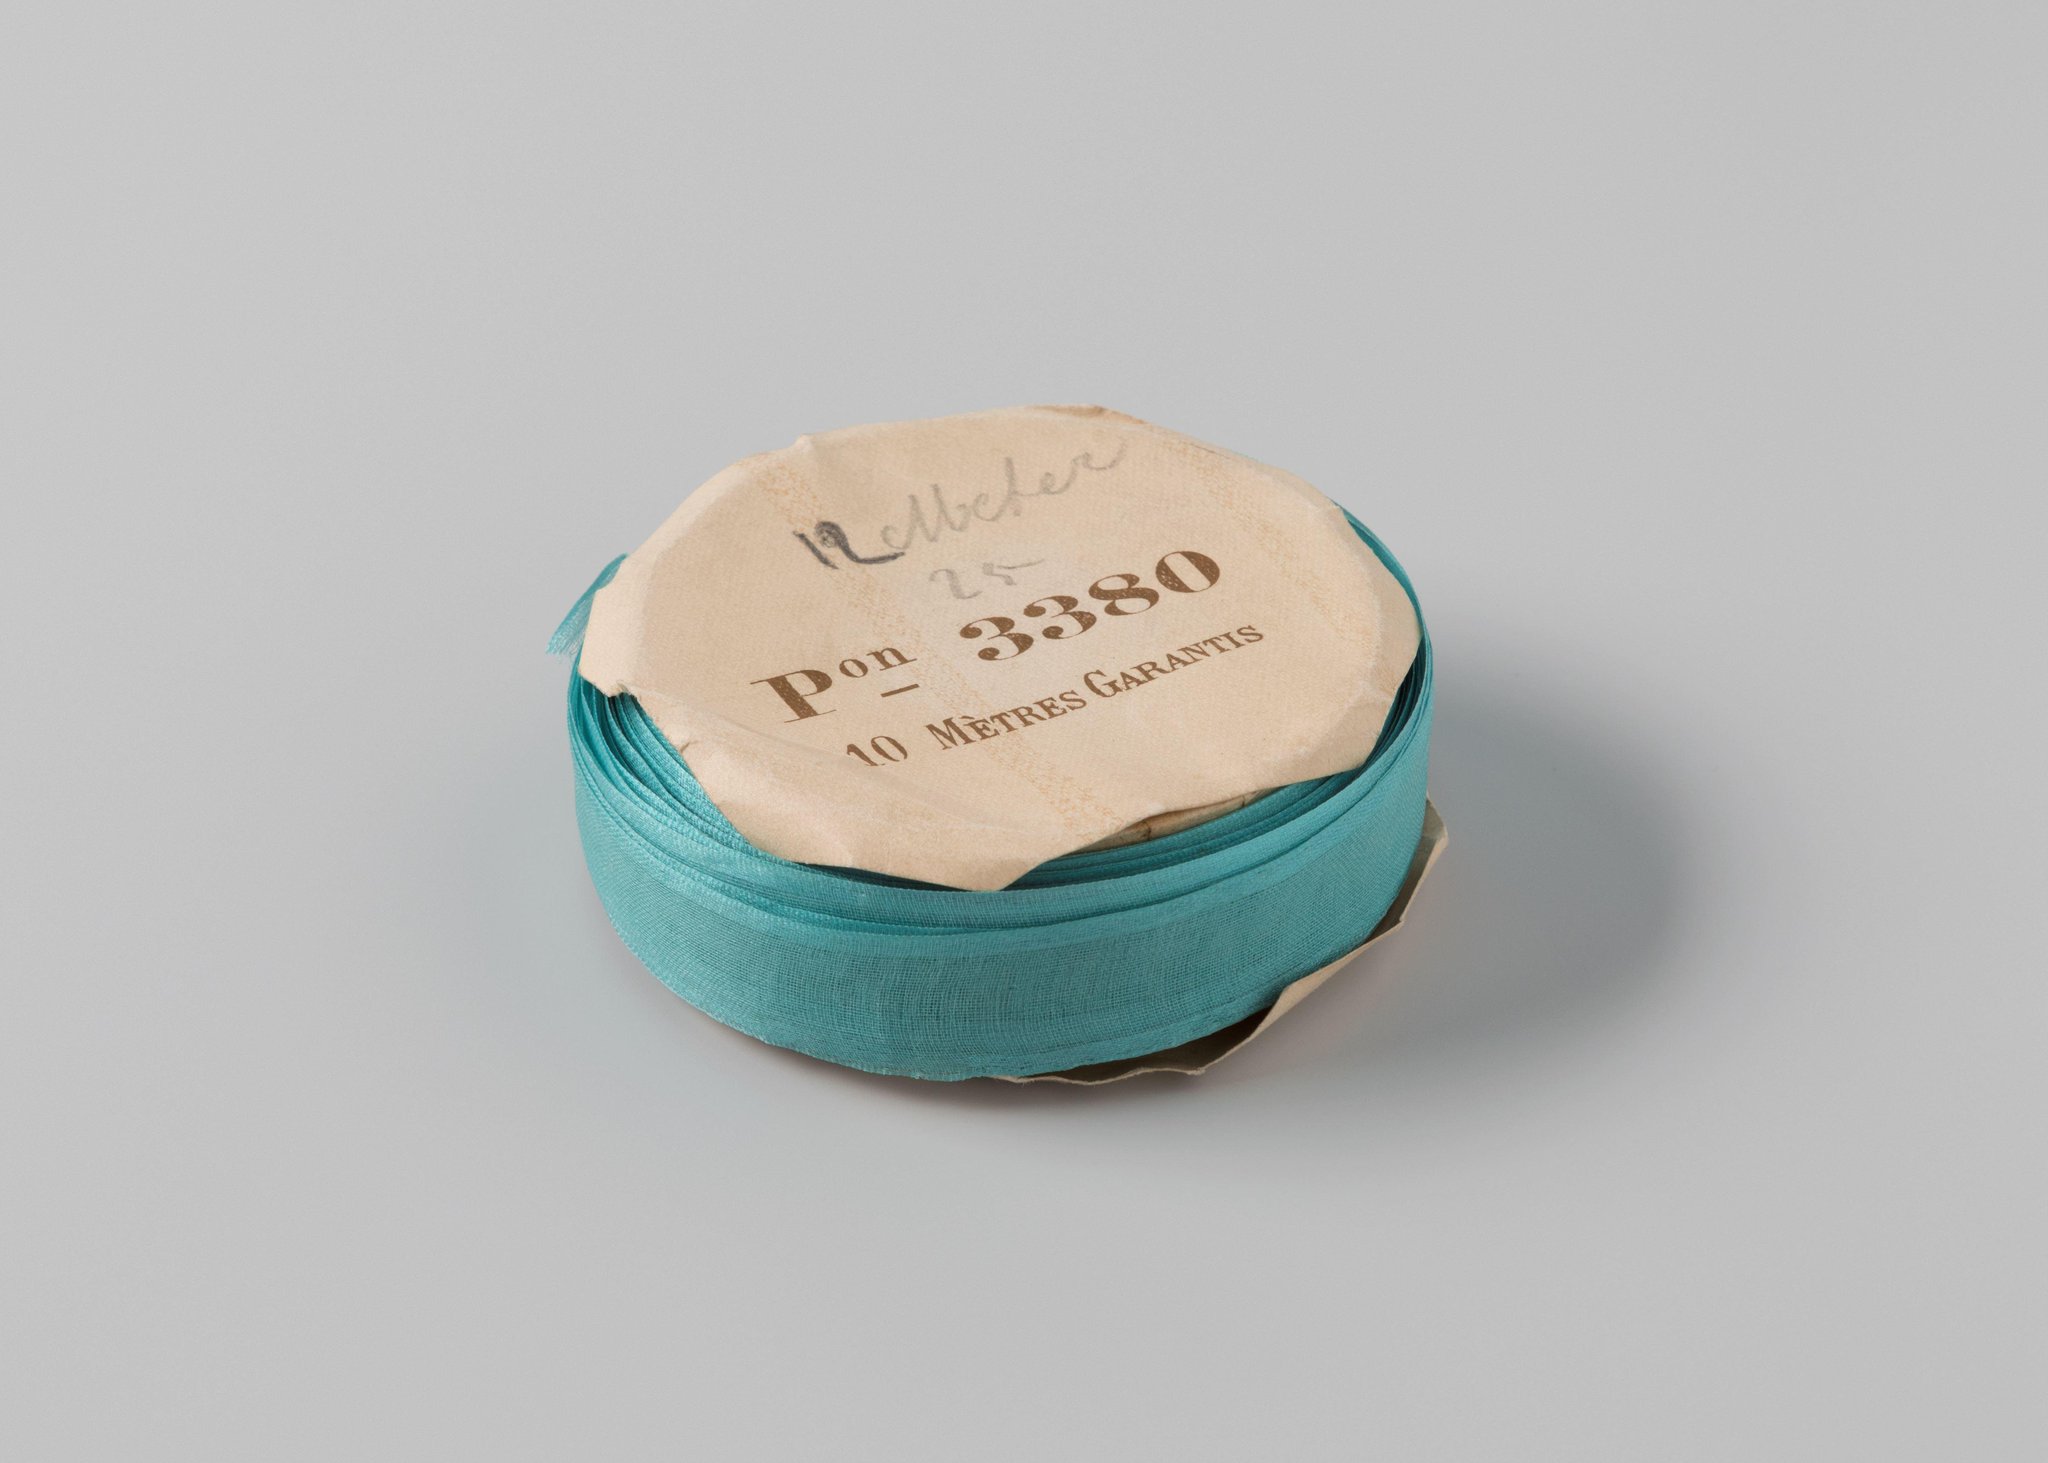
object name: ribbon material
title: Lint van turkoois gaas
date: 1900-1915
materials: textile, silk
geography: nijmegen